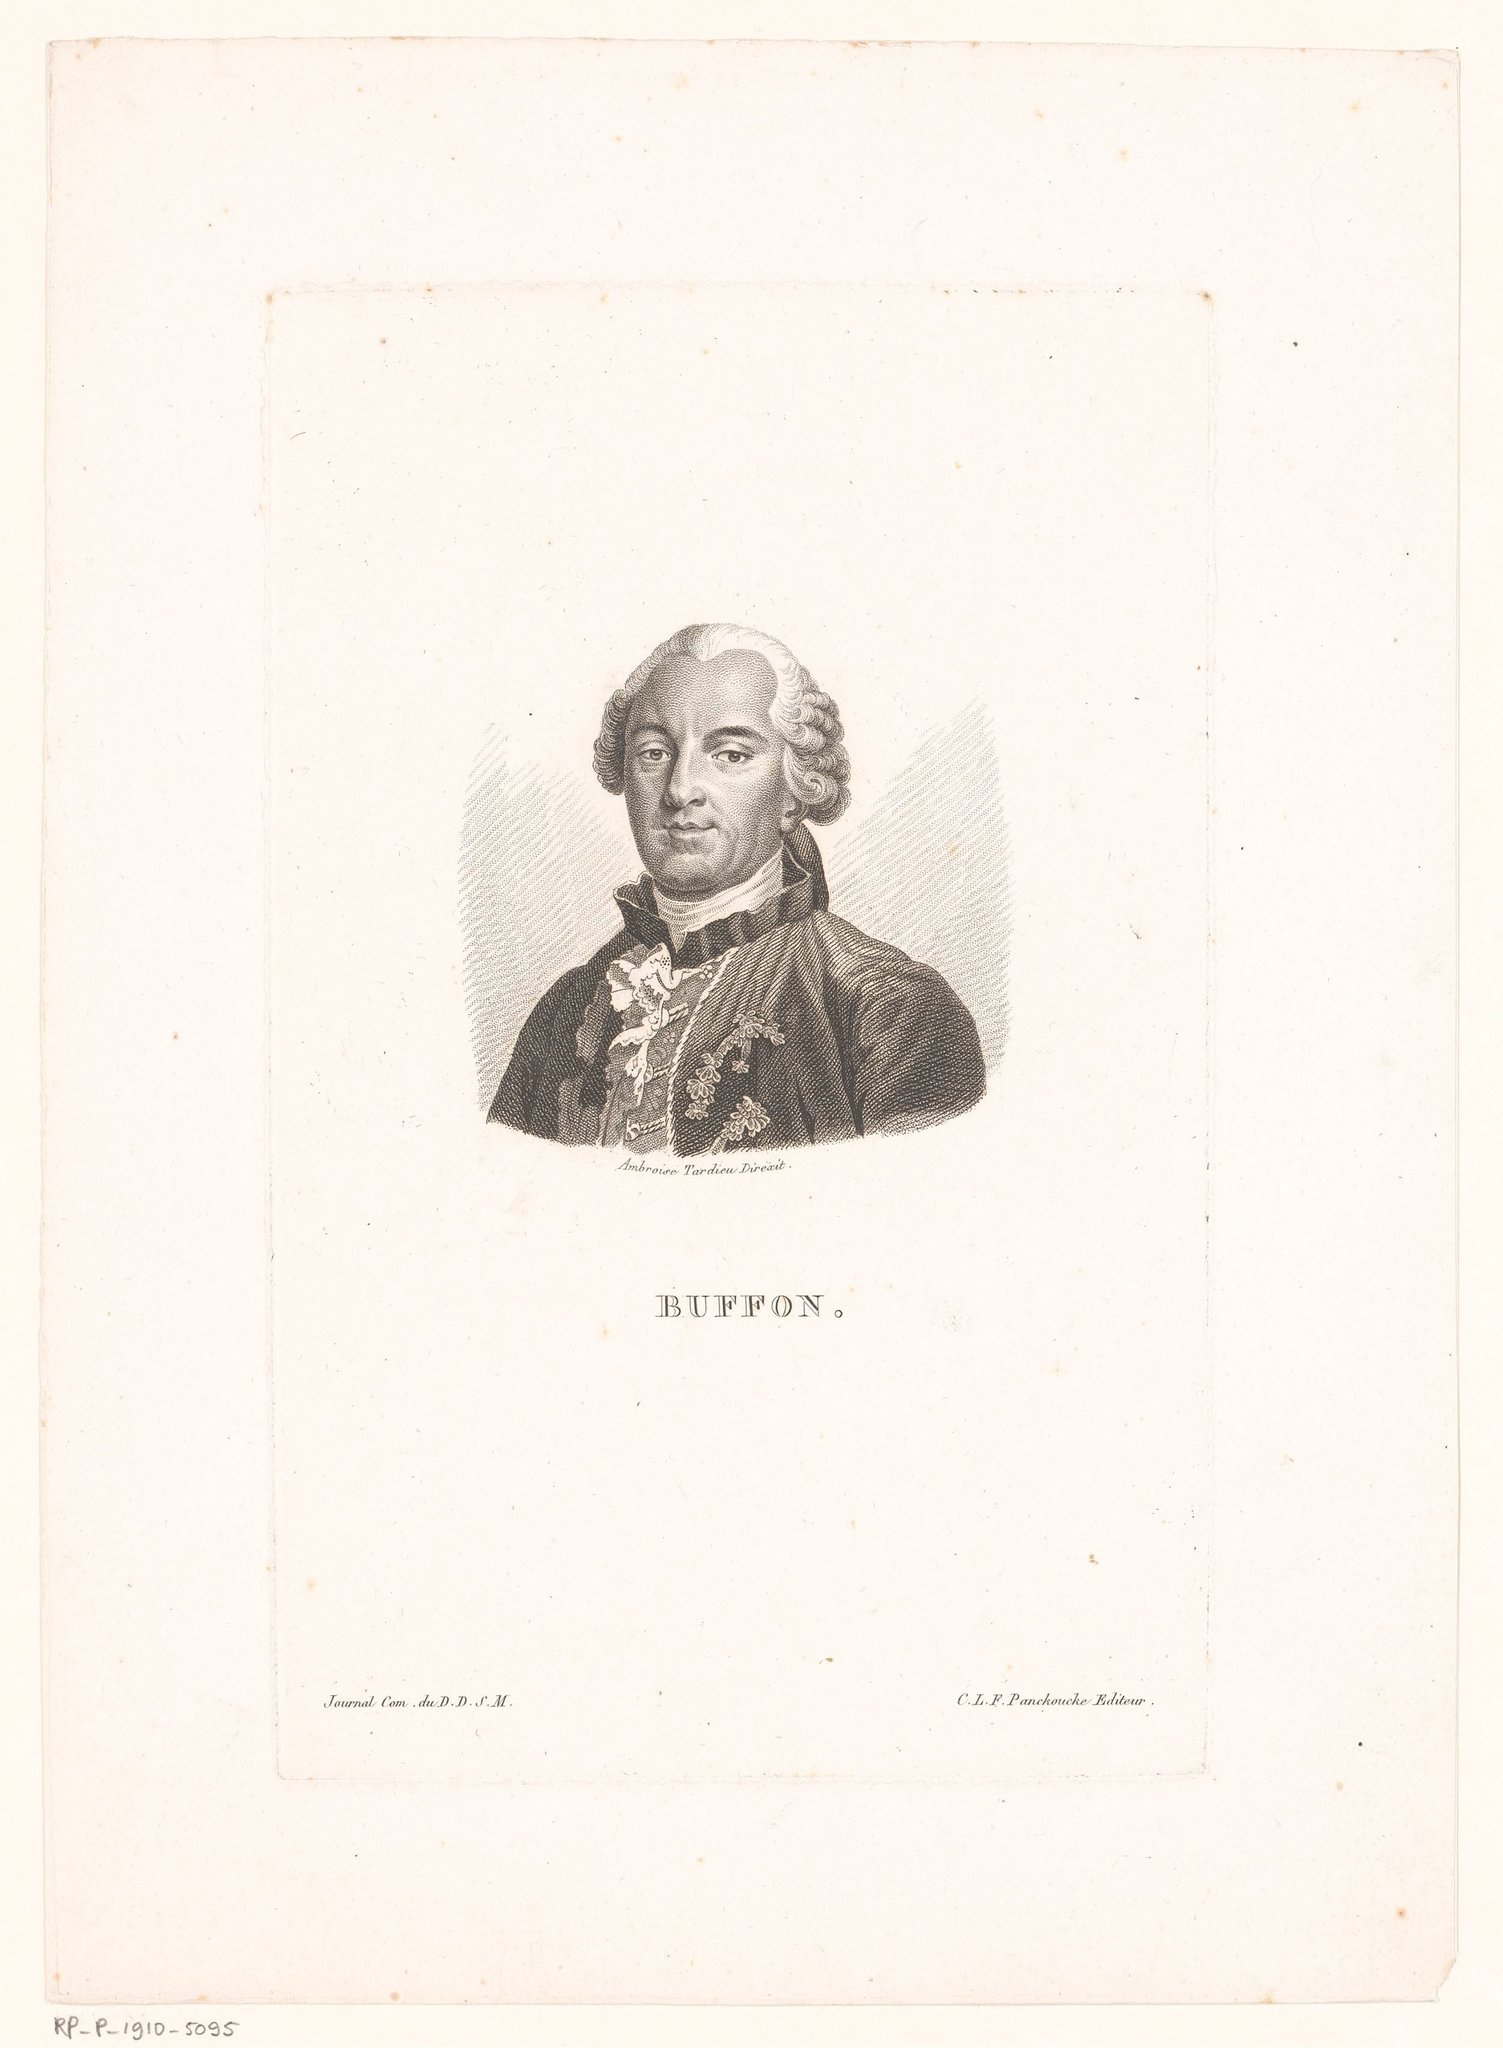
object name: book illustration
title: Portret van Georges-Louis Leclerc, graaf van Buffon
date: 1818-1832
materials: paper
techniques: engraving, roulette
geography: paris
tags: paris, georges-louis leclerc de buffon (graaf), scholar, philosopher, historical persons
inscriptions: collector's mark: Lugt 2228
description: Prent uit: Journal complémentaire du Dictionnaire des sciences médicales. Parijs: Panckoucke, Charles Louis Fleury, 1818-1832.